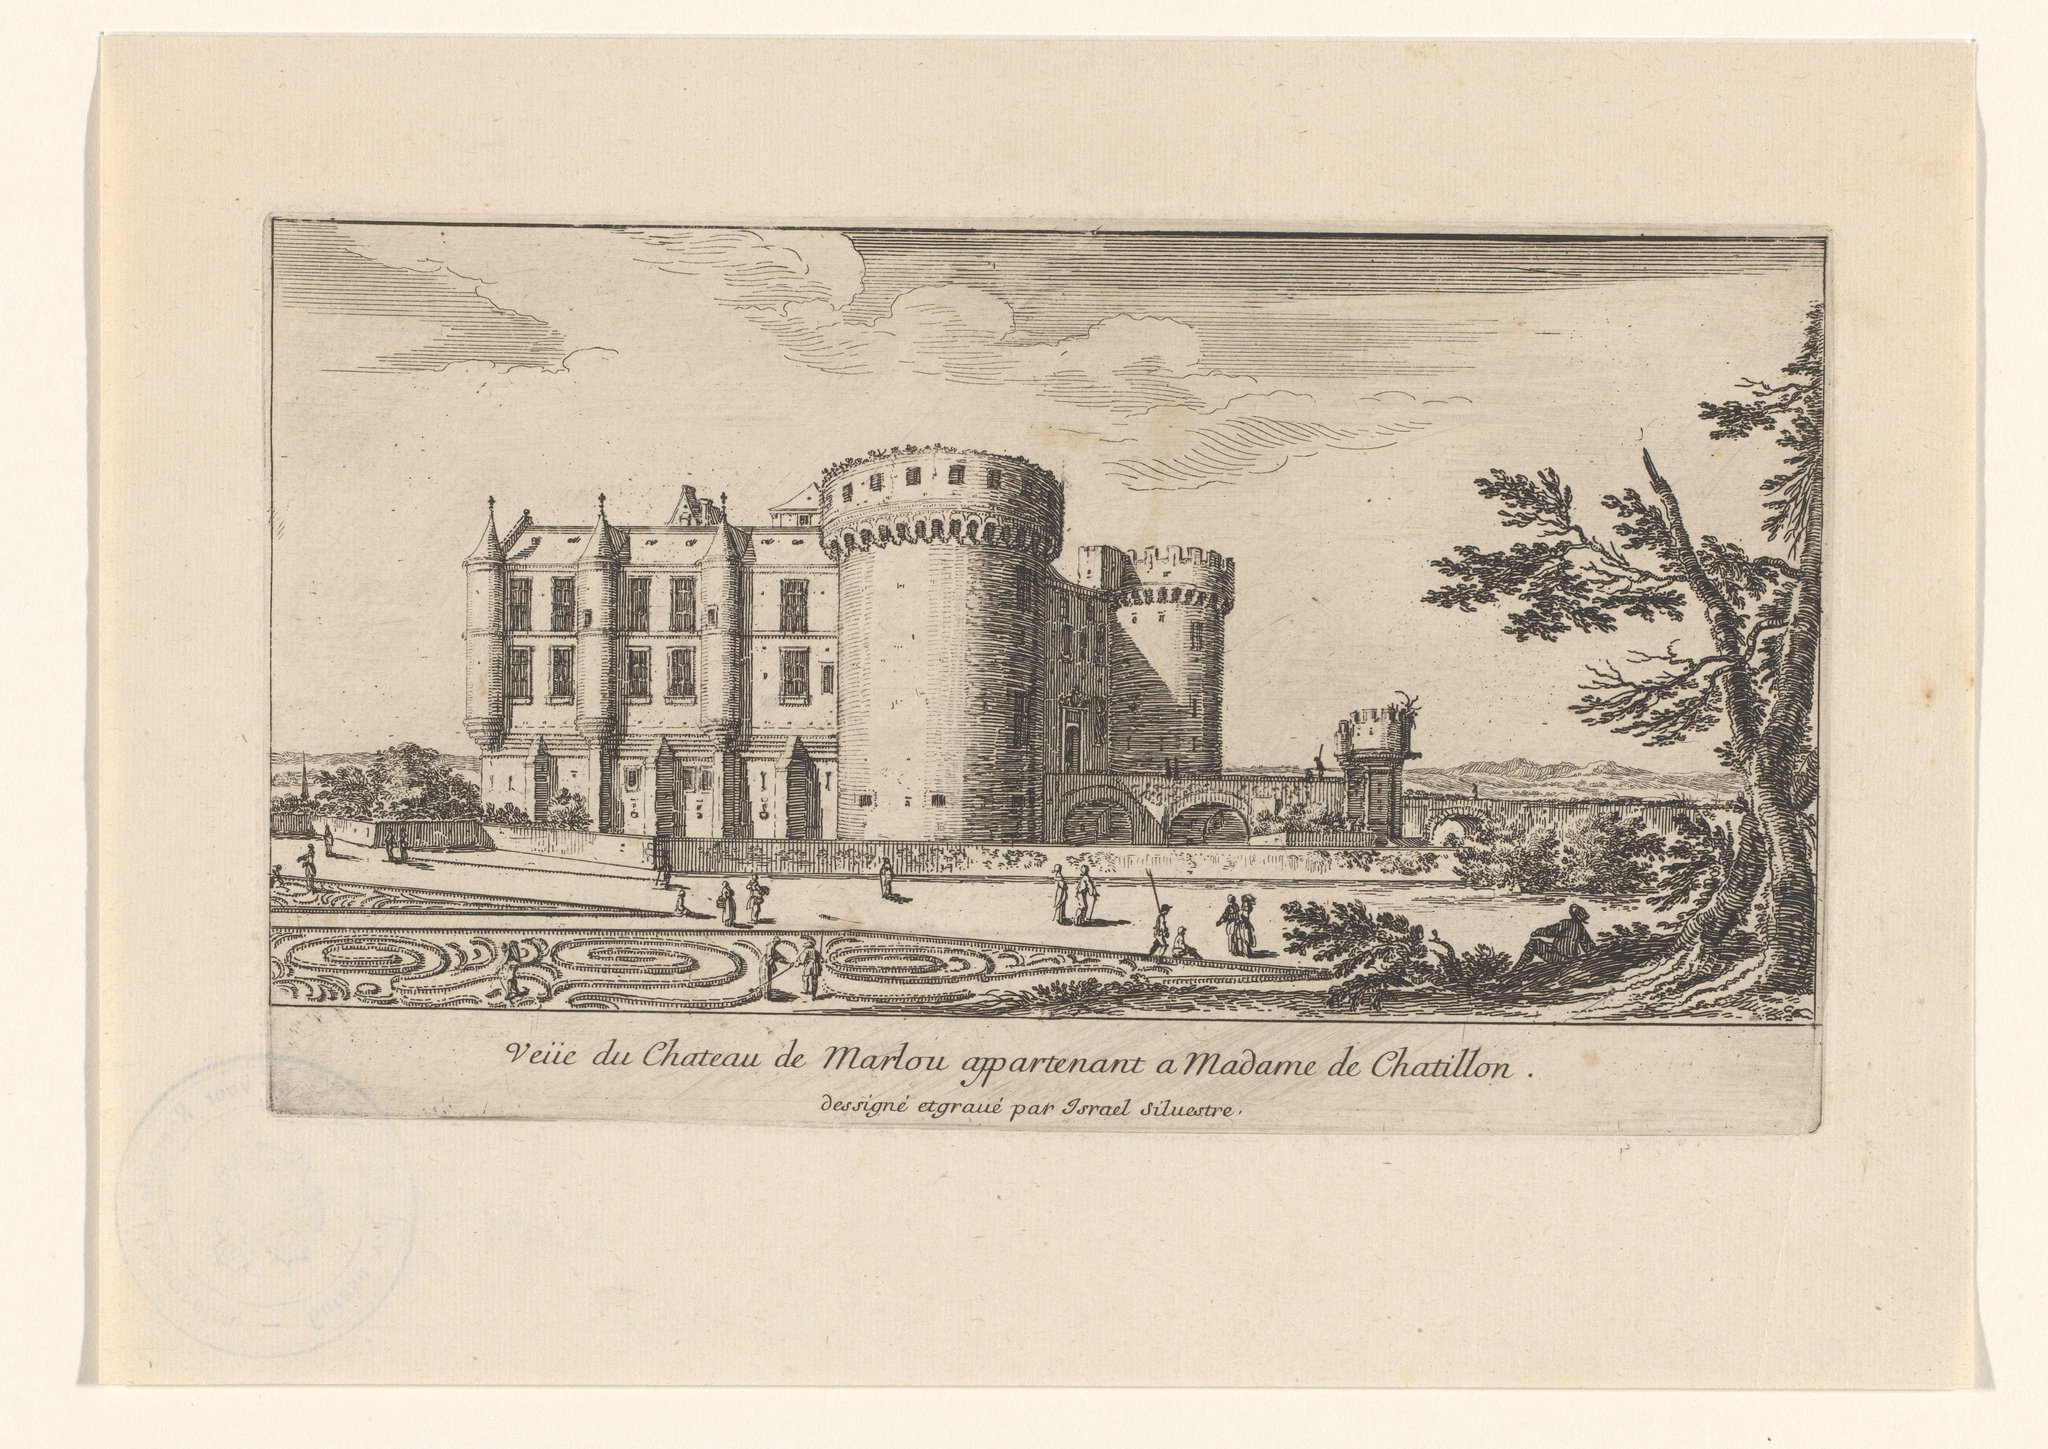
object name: print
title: Gezicht op kasteel de Mello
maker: israël silvestre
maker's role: draughtsman, print maker, publisher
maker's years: 1621-1691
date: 1646-1691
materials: paper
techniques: etching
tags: castle, french or architectonic garden; formal garden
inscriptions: stamp: ‘Bureau v.d. Rijksinspecteur voor Roerende Monumenten ’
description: Het kasteel behoorde volgens het onderschrift destijds aan 'Madame de Chatillon', mogelijk Elisabeth Angélique de Montmorency.